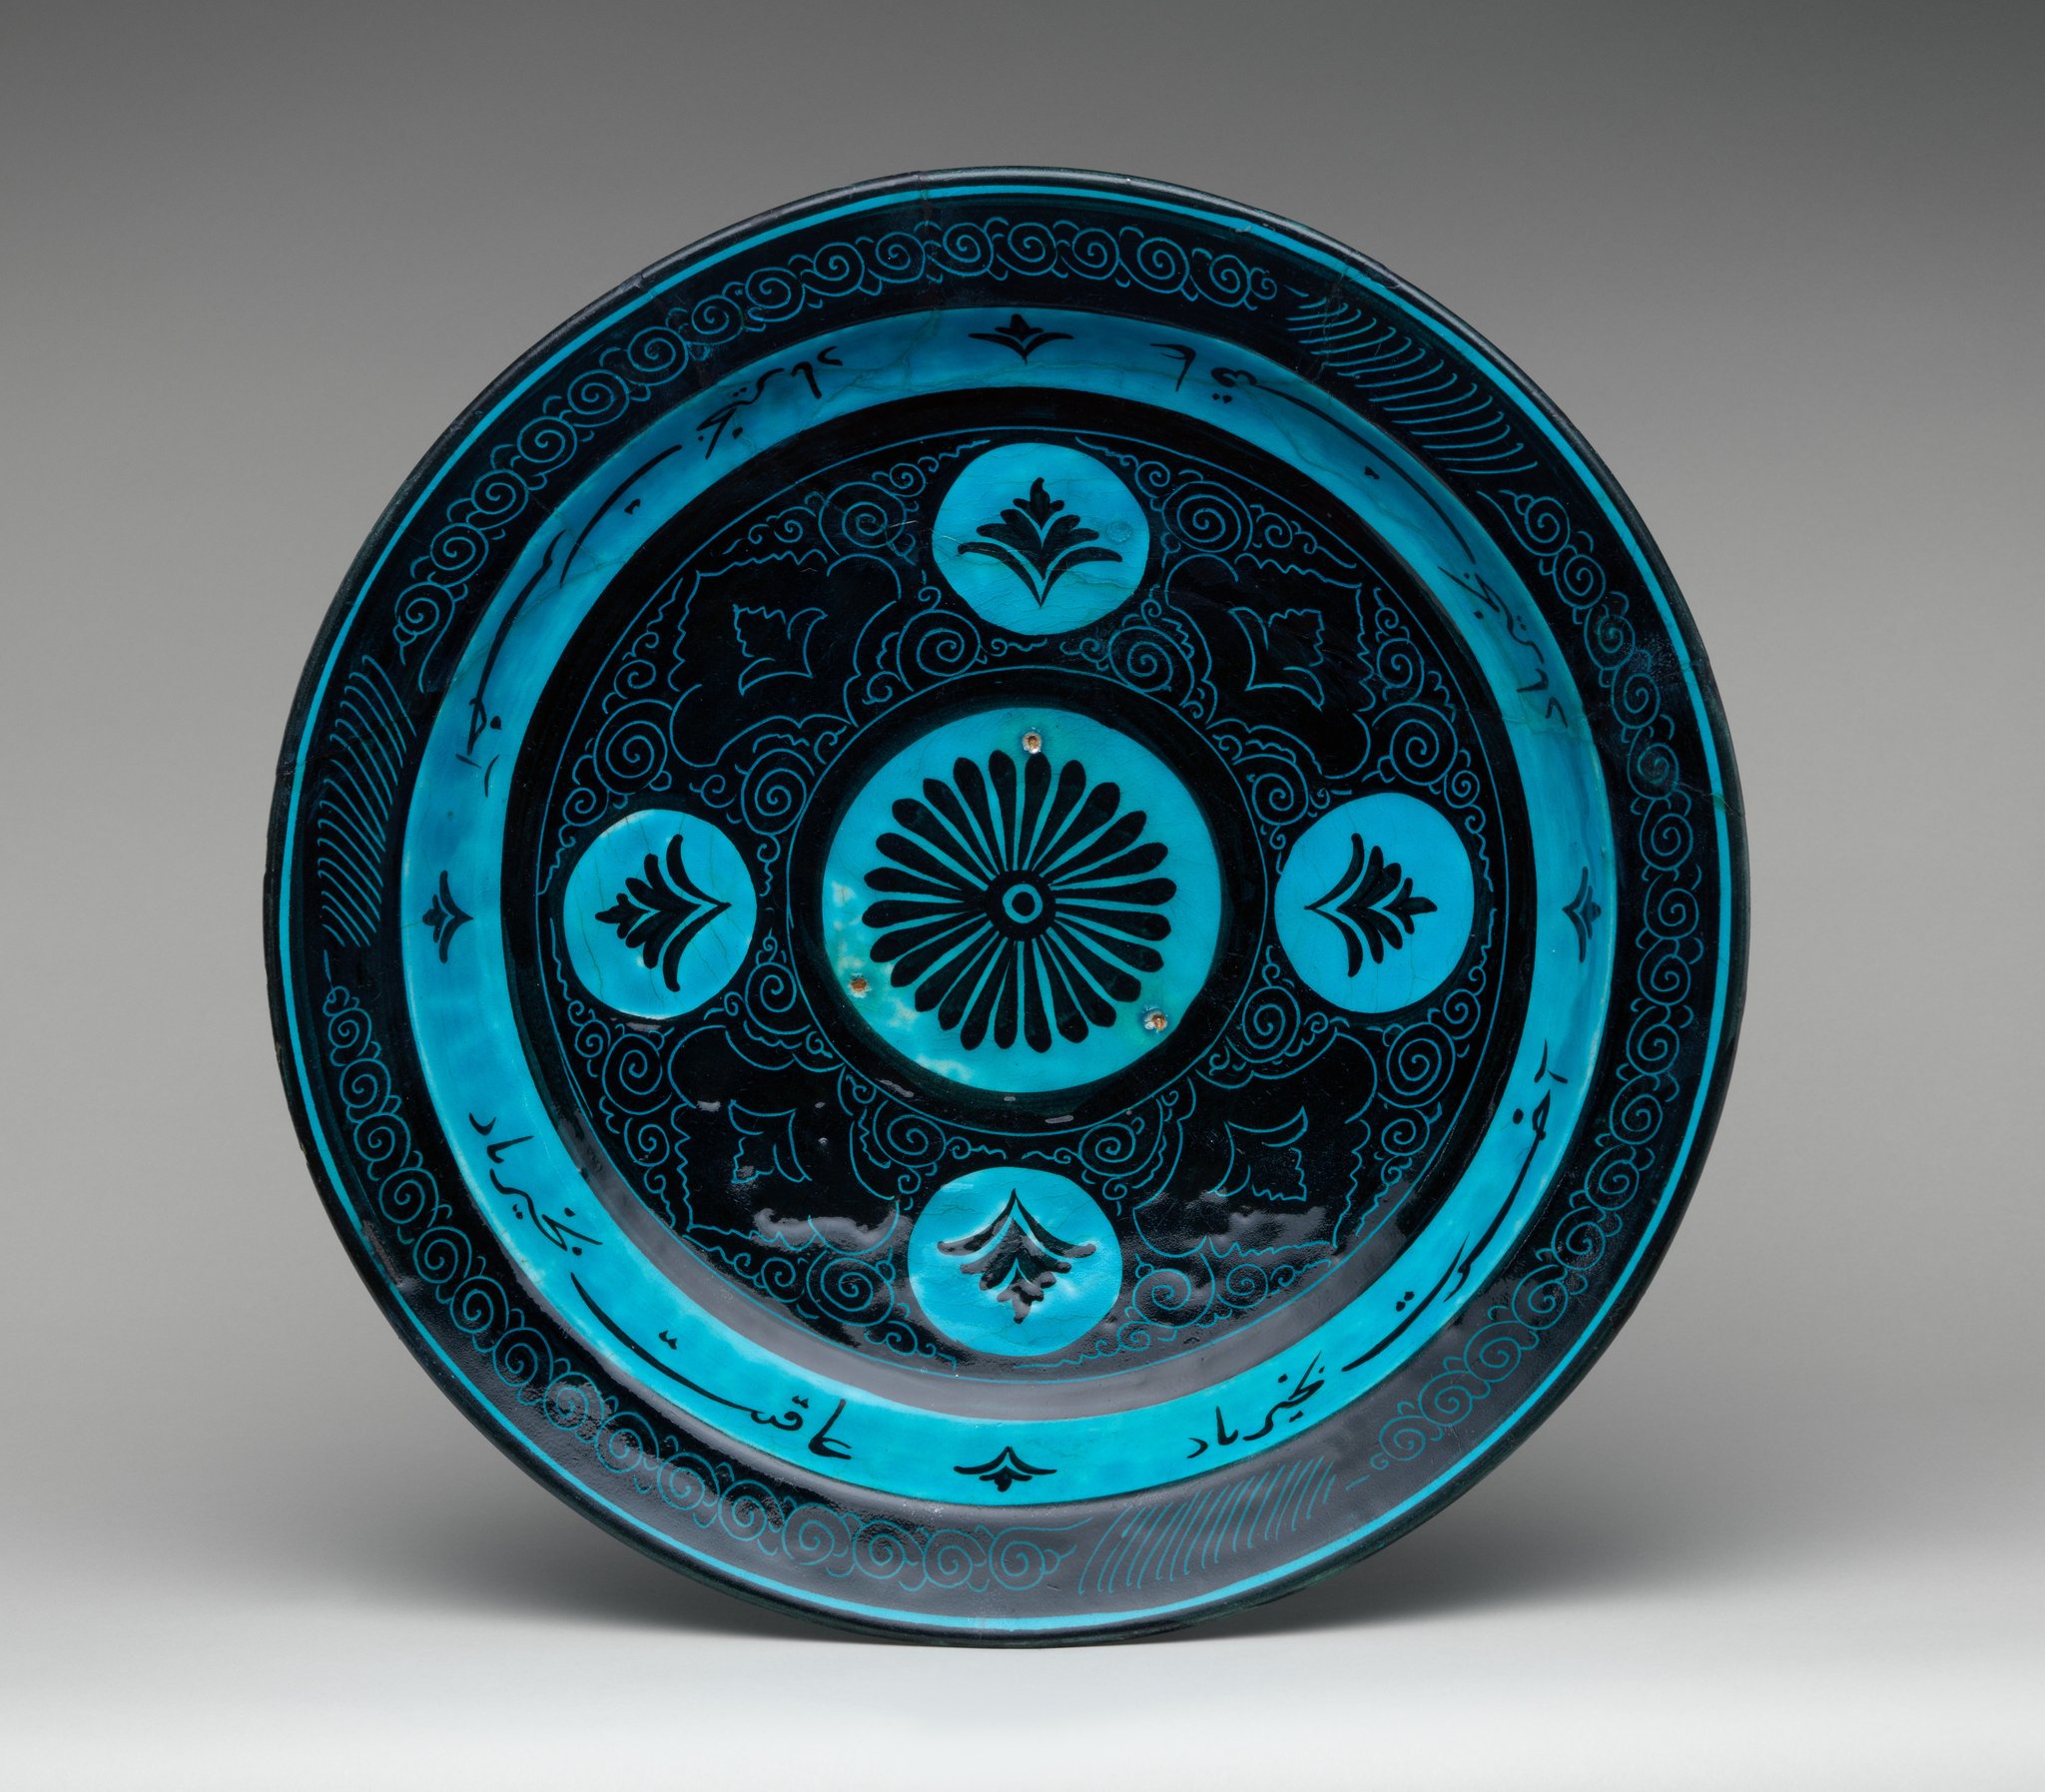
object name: dish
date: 1451-1500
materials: glaze, stonepaste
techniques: incising, painting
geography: iran